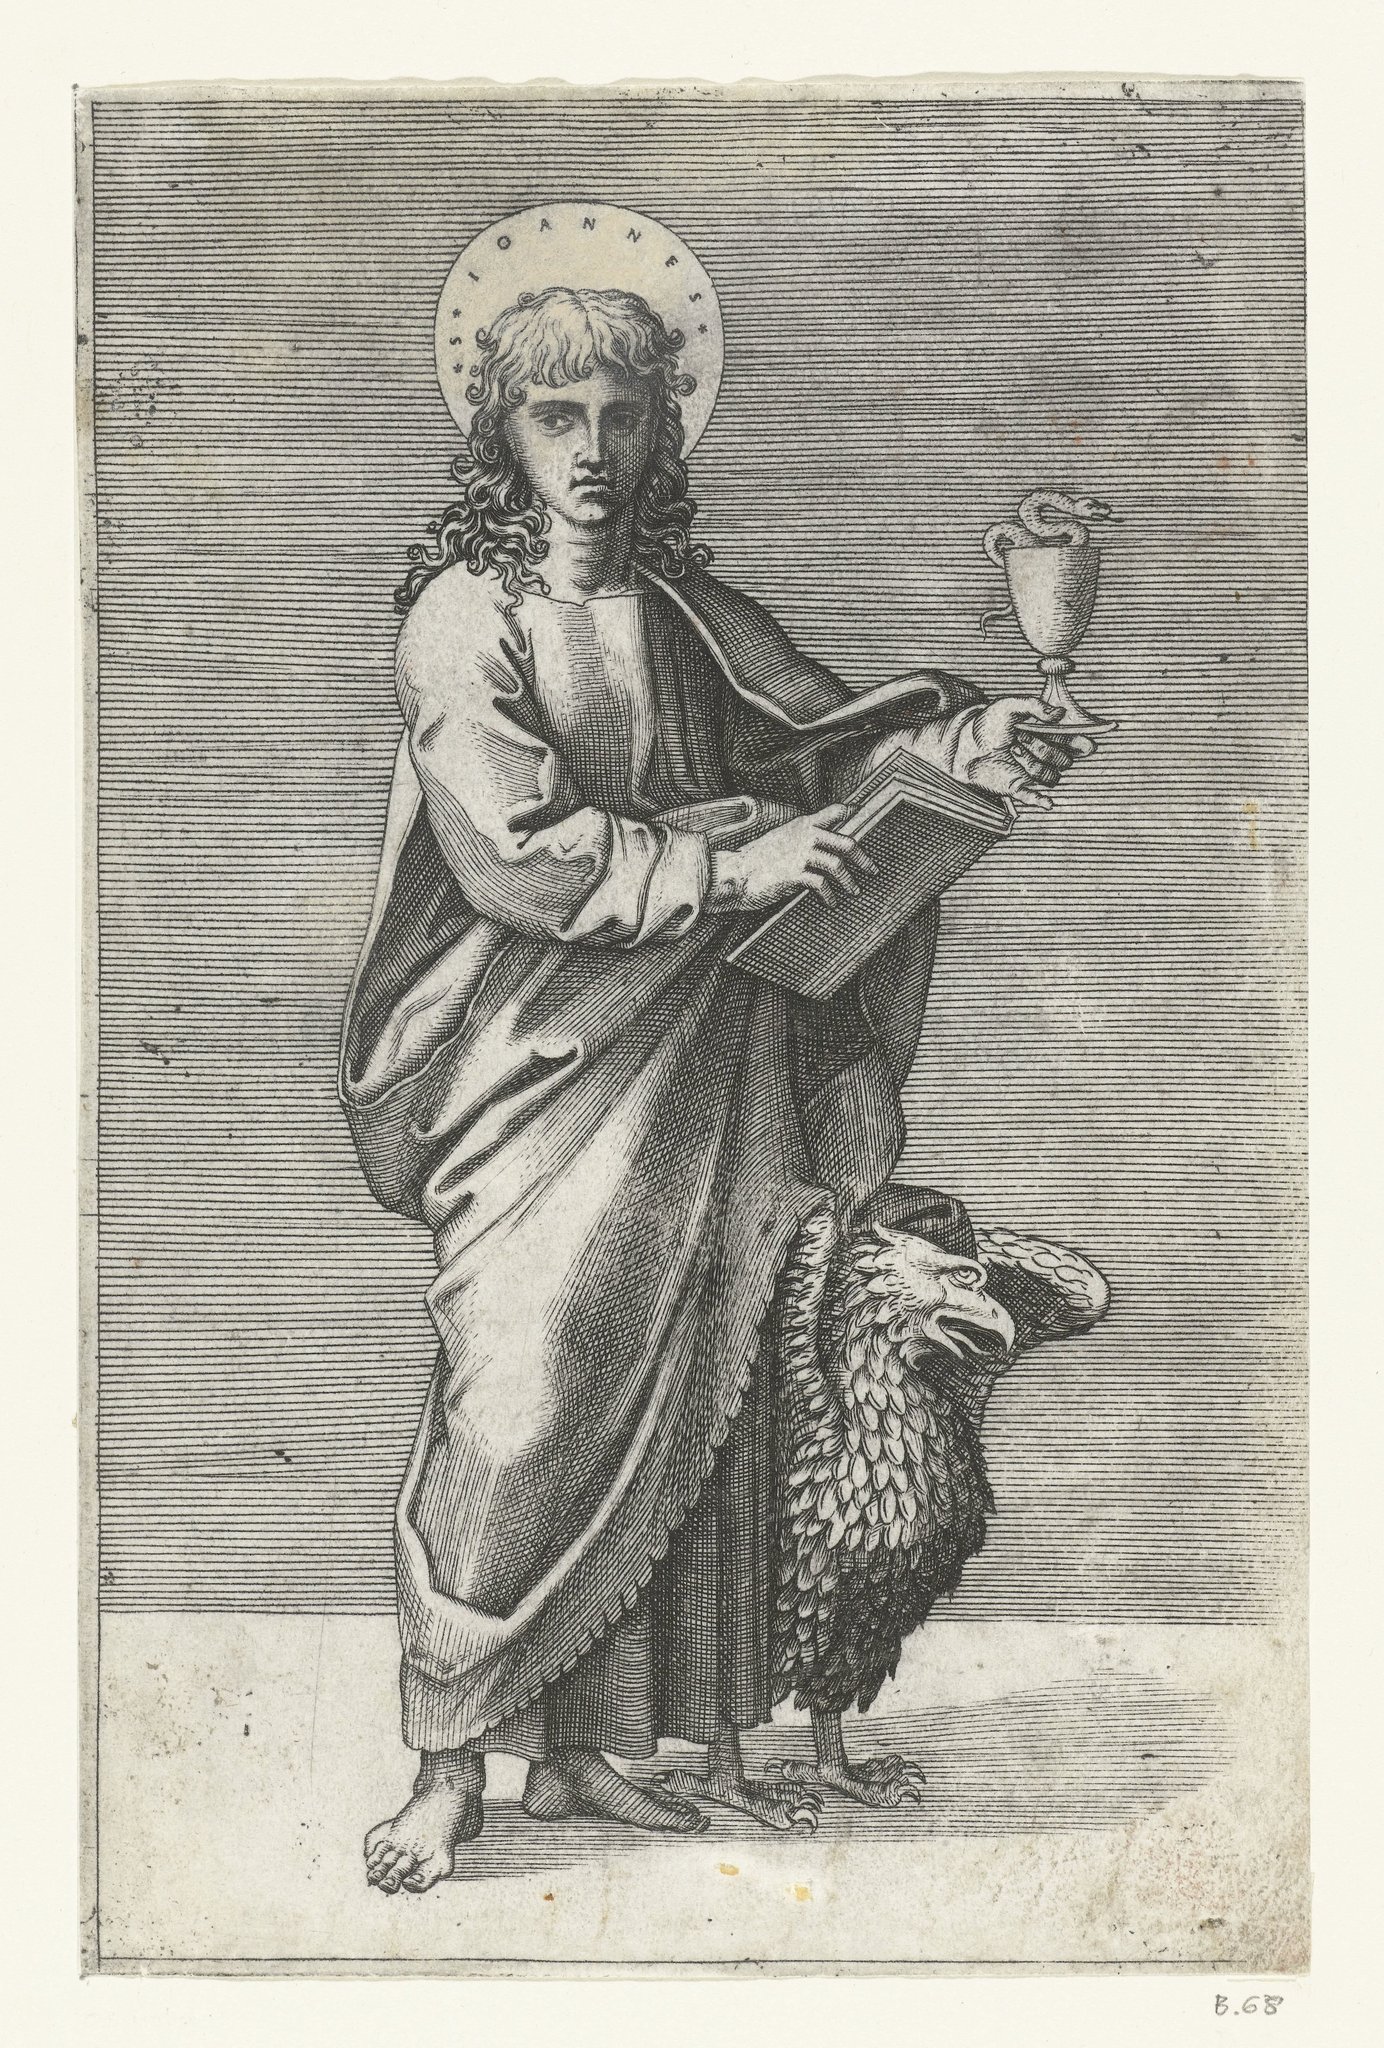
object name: print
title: S Ioannes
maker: marcantonio raimondi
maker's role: print maker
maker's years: 1470-1534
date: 1517-1527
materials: paper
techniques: engraving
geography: italy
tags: the apostle john the evangelist; possible attributes: book, cauldron, chalice with snake, eagle, palm, scroll